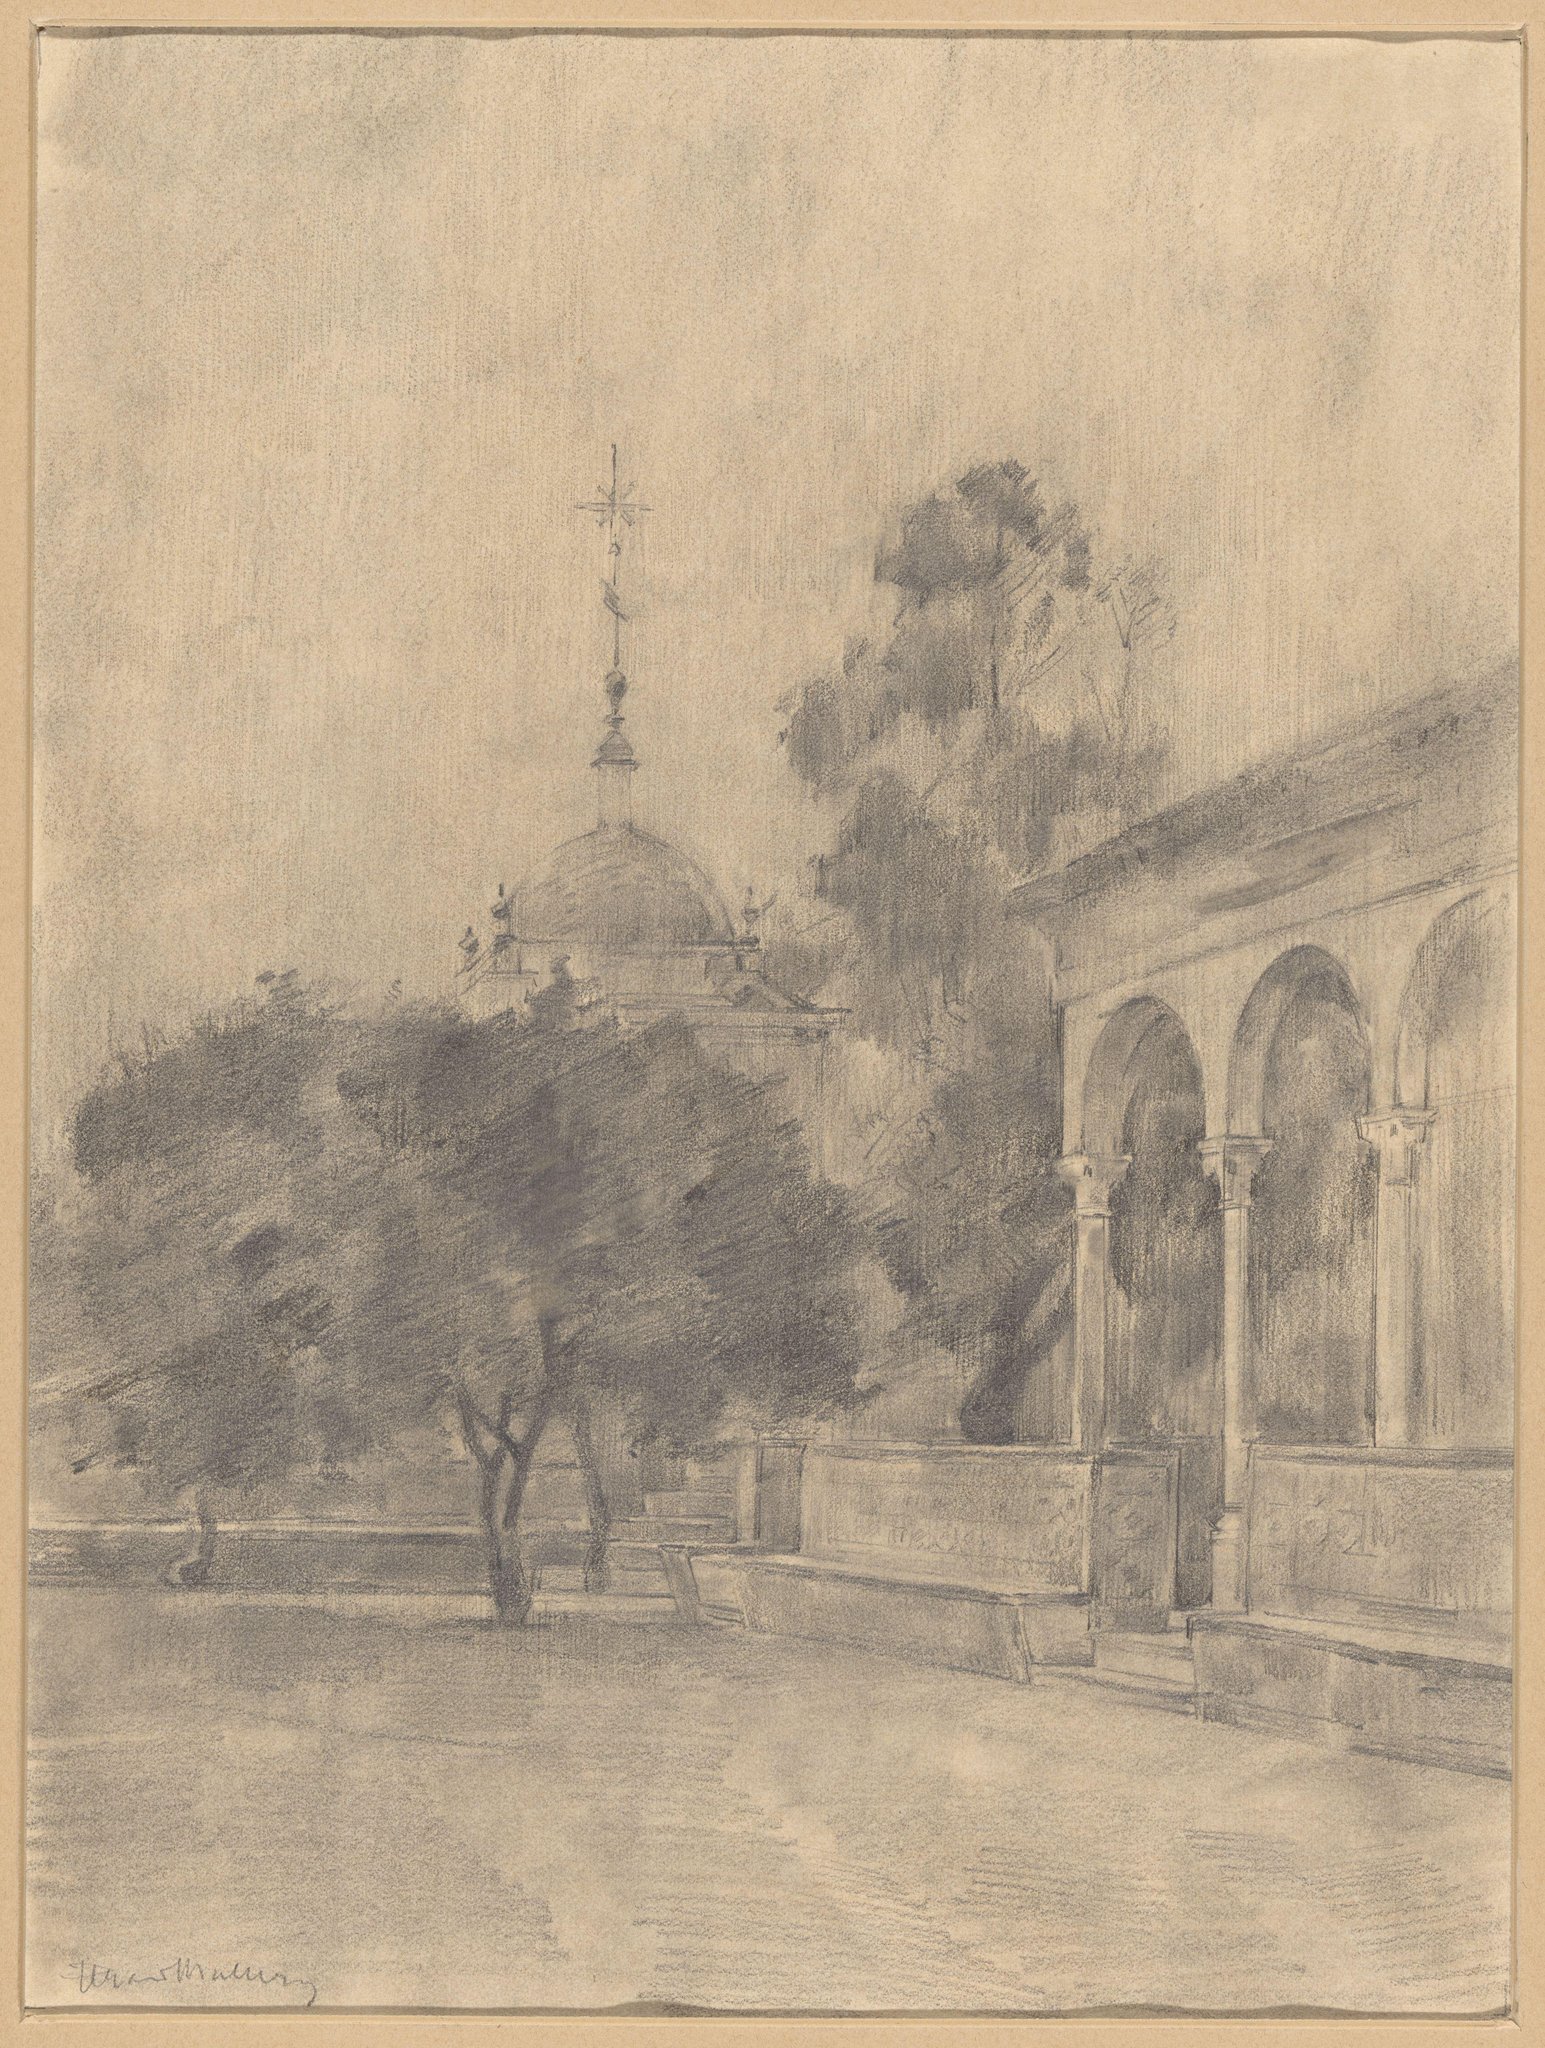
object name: drawing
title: Paviljoen van Karel V in het Koninklijk Paleis te Sevilla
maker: gerard muller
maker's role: draughtsman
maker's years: 1861-1929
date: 1871-1903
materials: chalk, paper, pencil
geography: sevilla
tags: palace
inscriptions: label: ‘26. Alcázar Sevilla./ Pavilloen Karel V.’, collector's mark: Lugt 2228